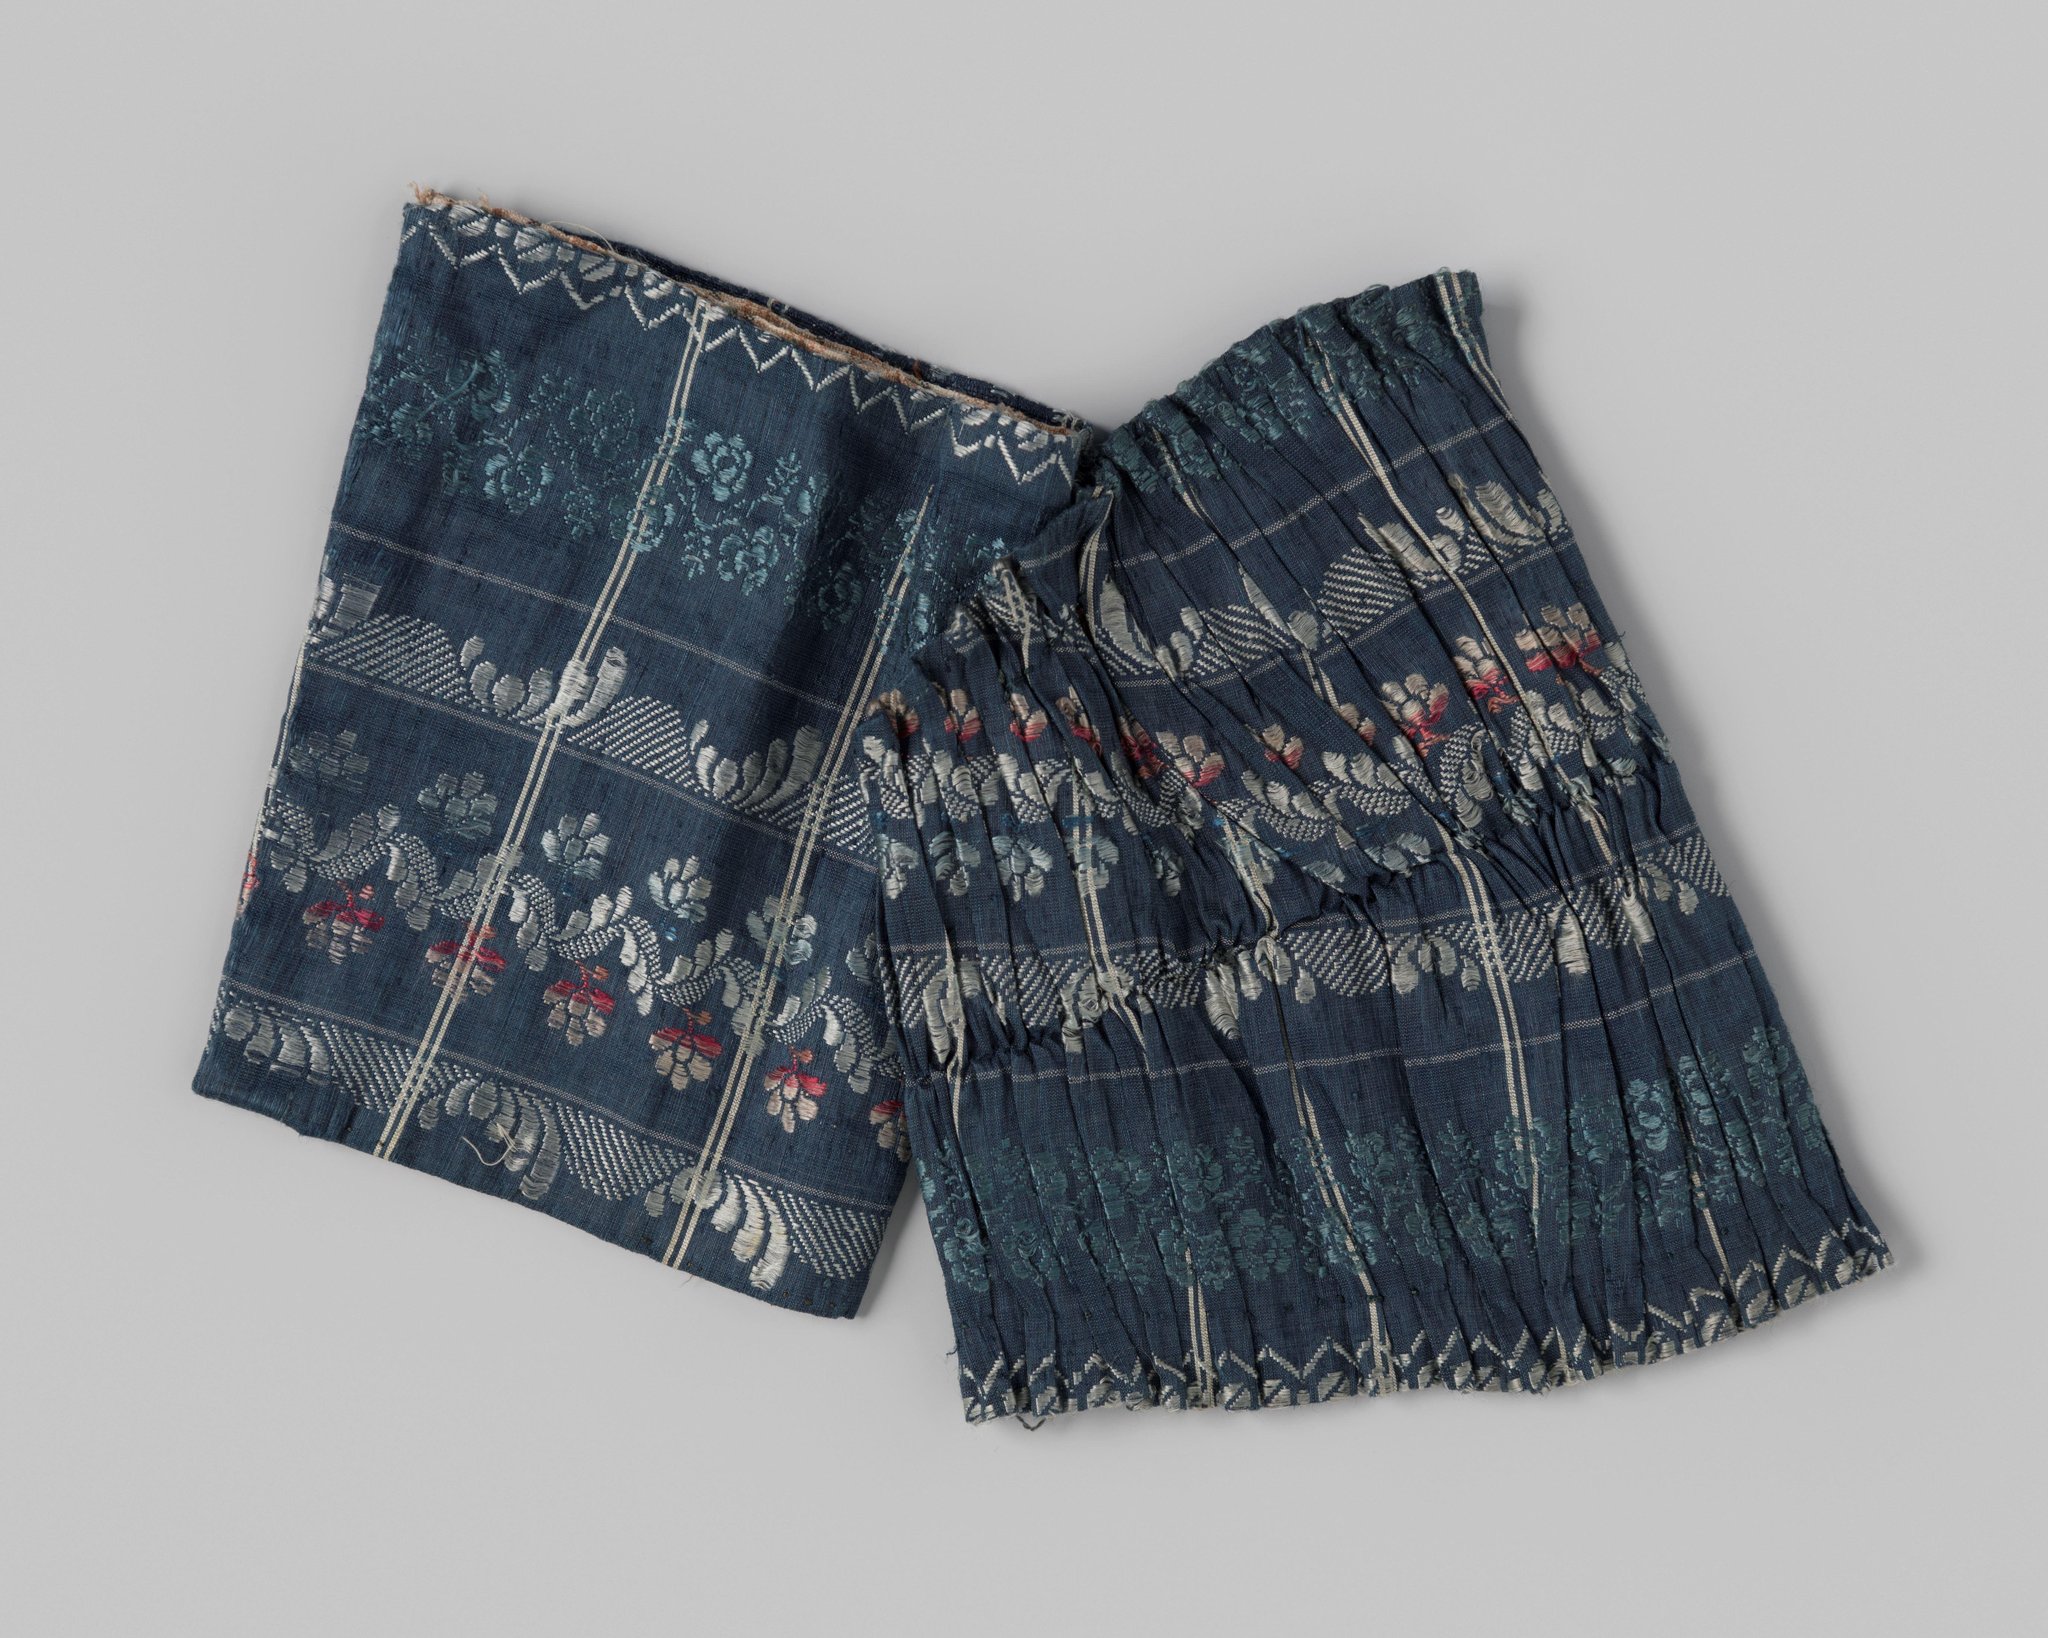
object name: main garment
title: Manchet van een robe à l'Anglaise van blauwe zijde met ruit- en bloemmotief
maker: Anonymous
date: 1760-1775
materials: linen, silk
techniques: embroidered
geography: western europe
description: Manchet van een robe à l'Anglaise van blauwe zijde met ingeweven ruitmotief en geborduurd bloemmotief, gevoerd met geruit linnen.